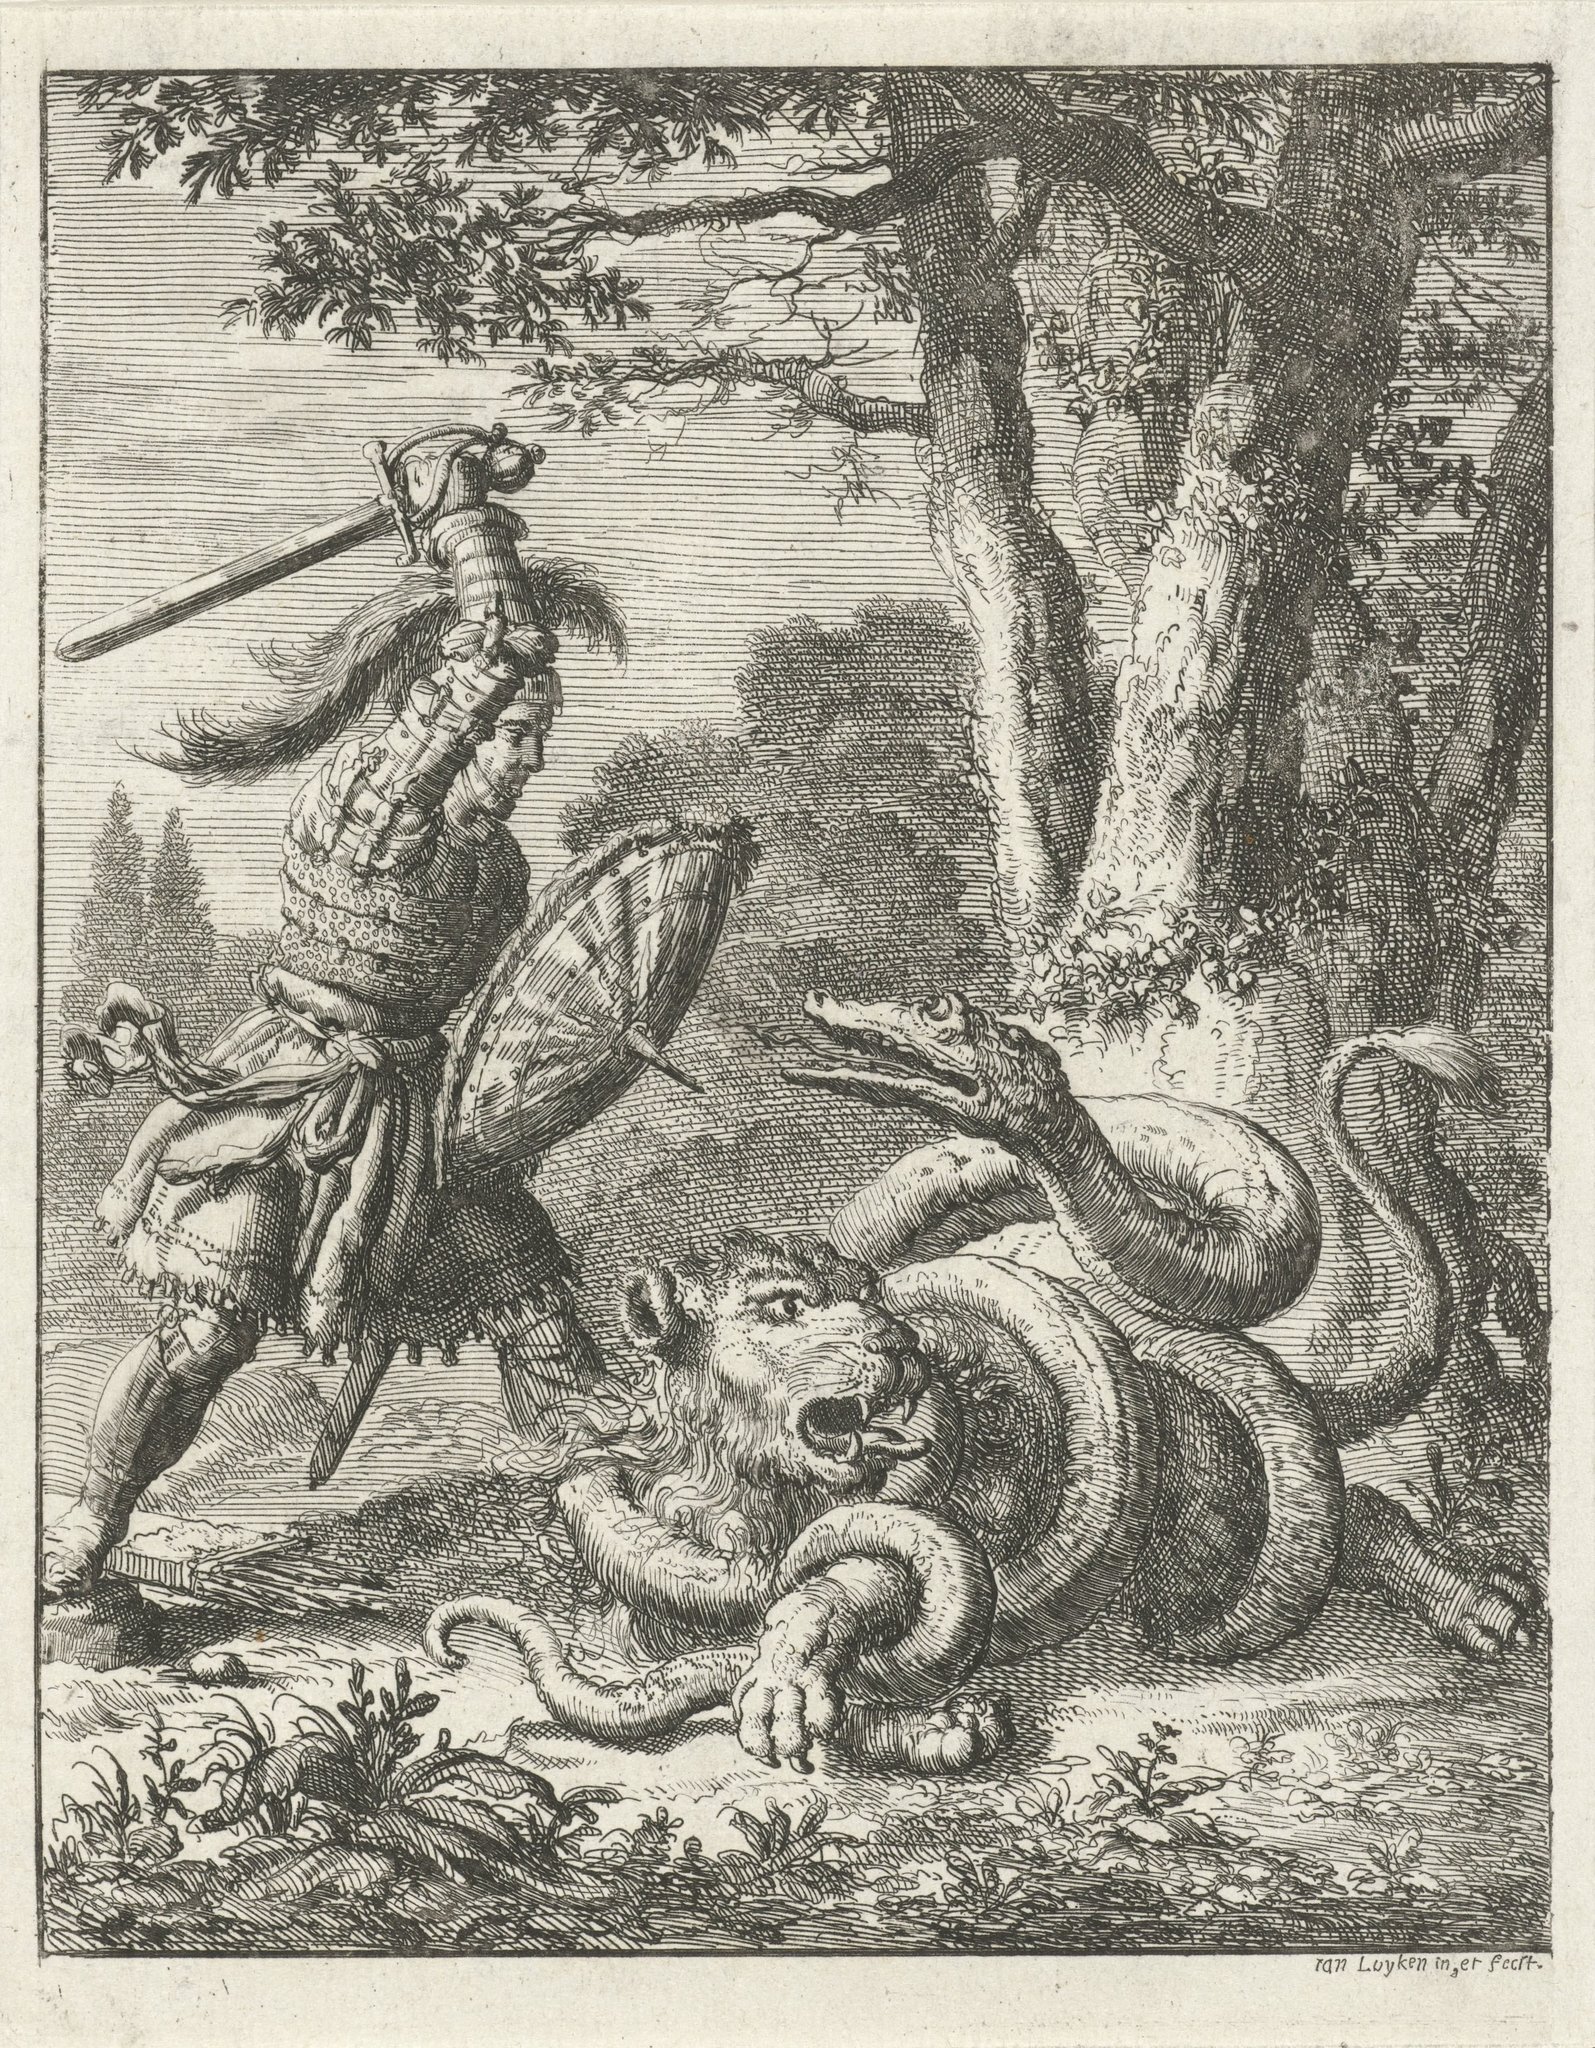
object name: book illustration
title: Godfried van Bouillon verlost een leeuw uit de wurggreep van een slang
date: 1683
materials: paper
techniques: etching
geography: amsterdam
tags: godfrey of bouillon, snakes (+ fighting animals; aggressive relations), militant proselytizing: religious war, crusade, etc., man killing animal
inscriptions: collector's mark: Lugt 2228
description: Illustratie opgenomen in: Maimbourg, Louis. Historie der kruisvaarders, tot de verlossing van't heilig land. Amsterdam: Timotheus ten Hoorn, 1683, p. 120.